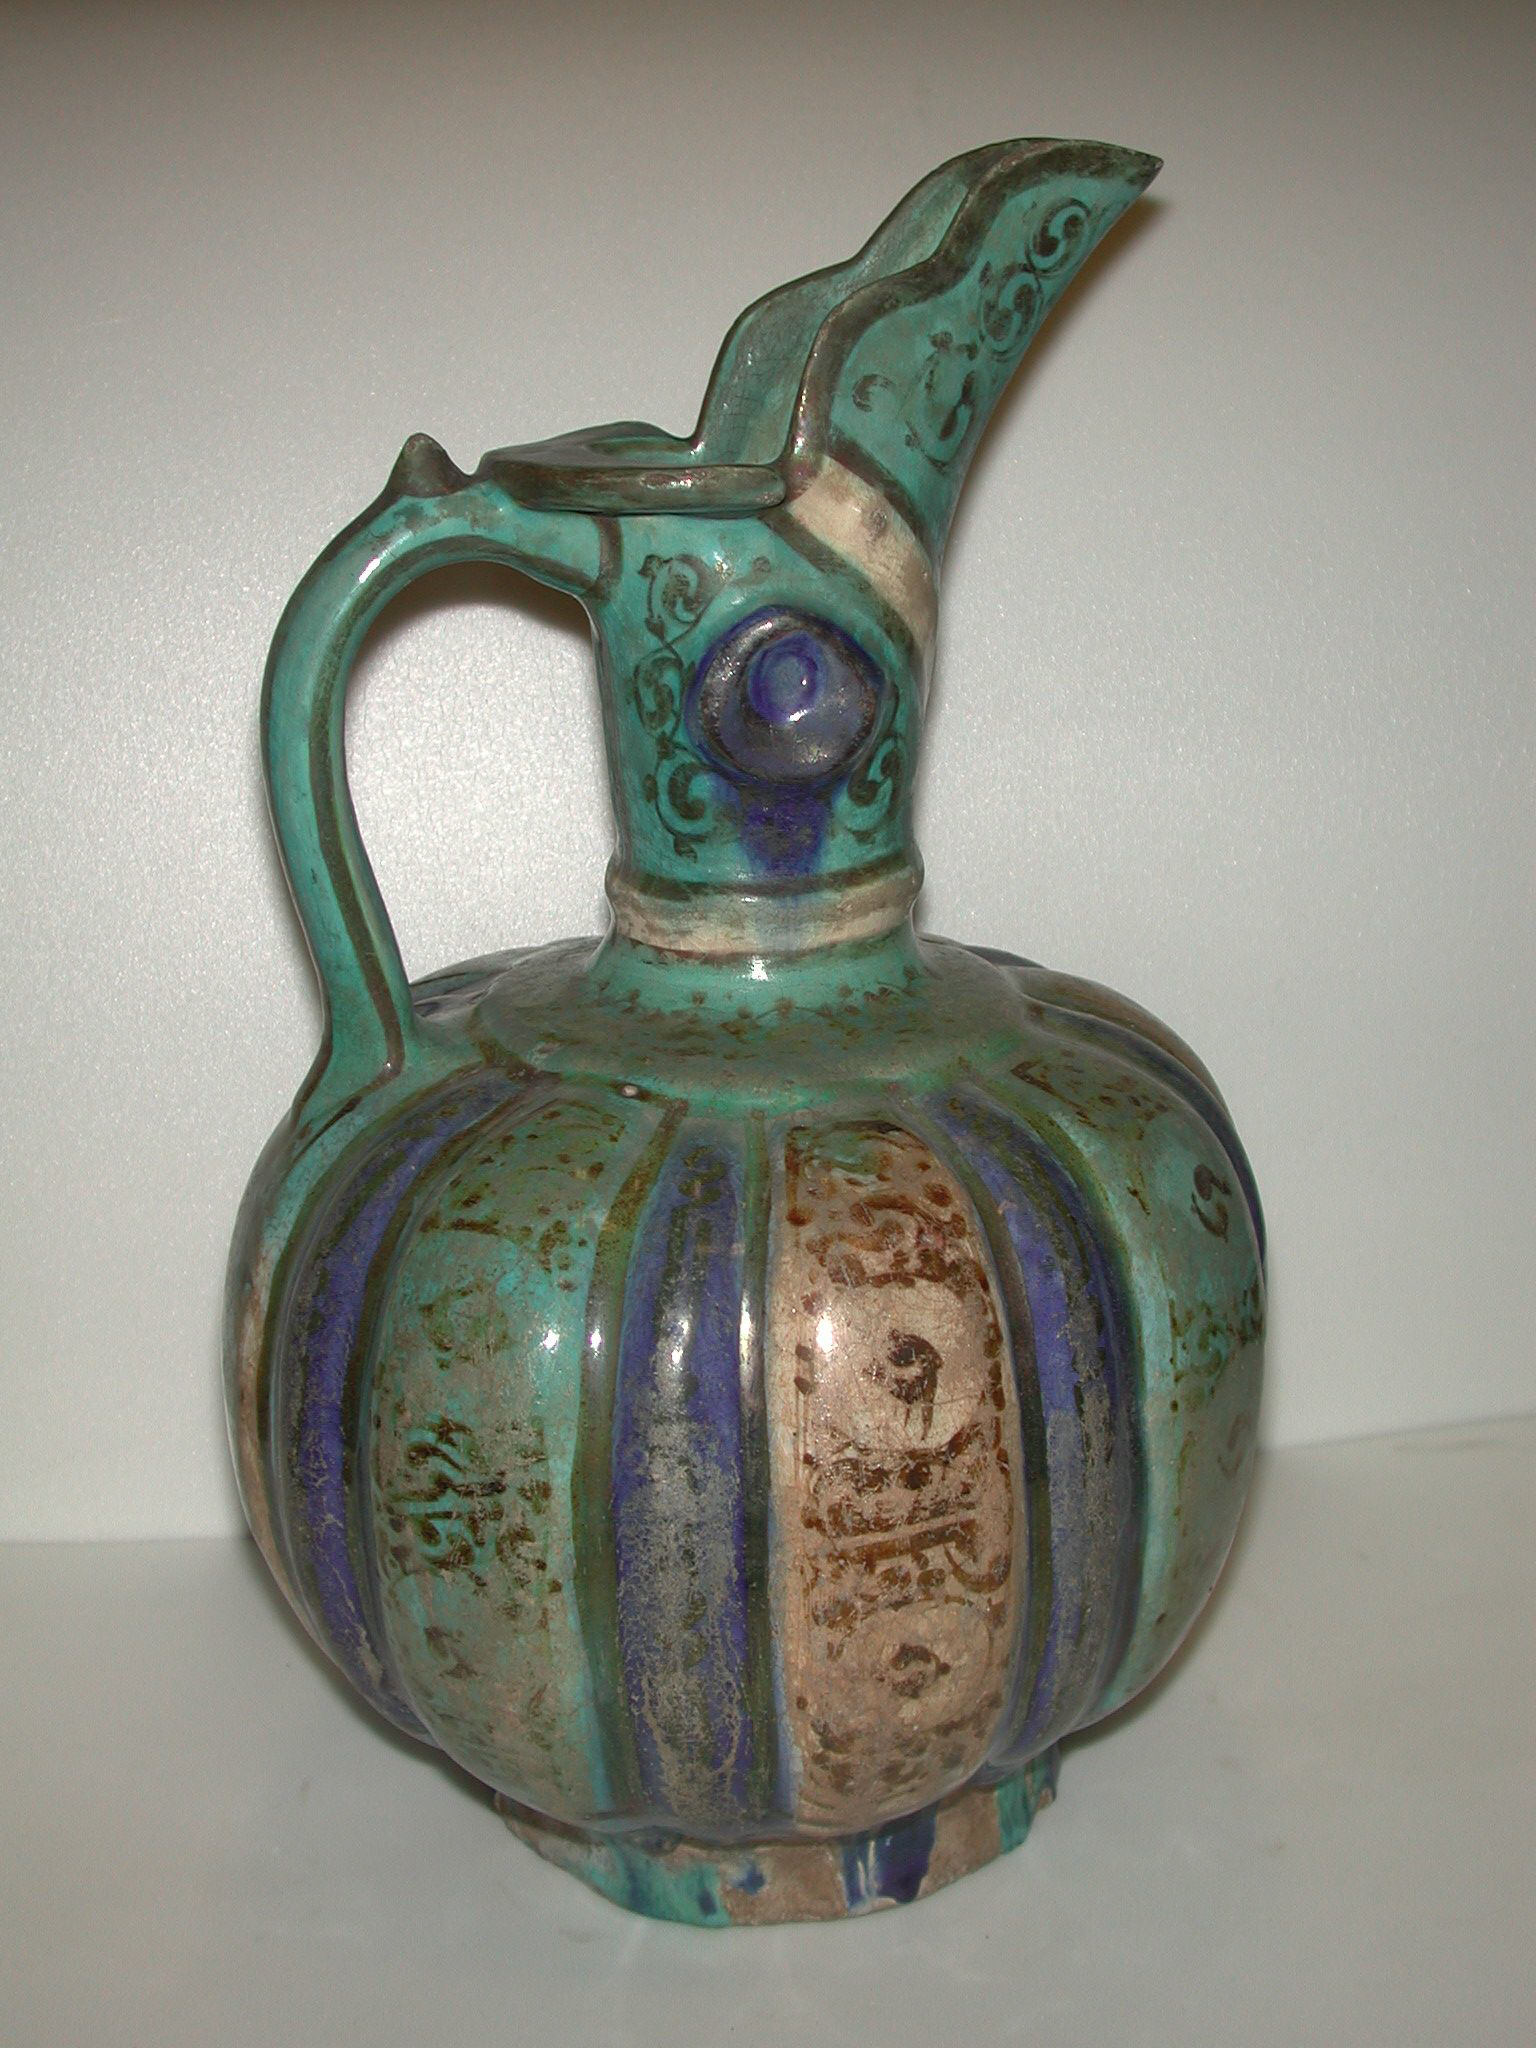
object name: ewer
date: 1101-1300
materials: stonepaste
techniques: luster painting, molding, painting, underglaze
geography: iran